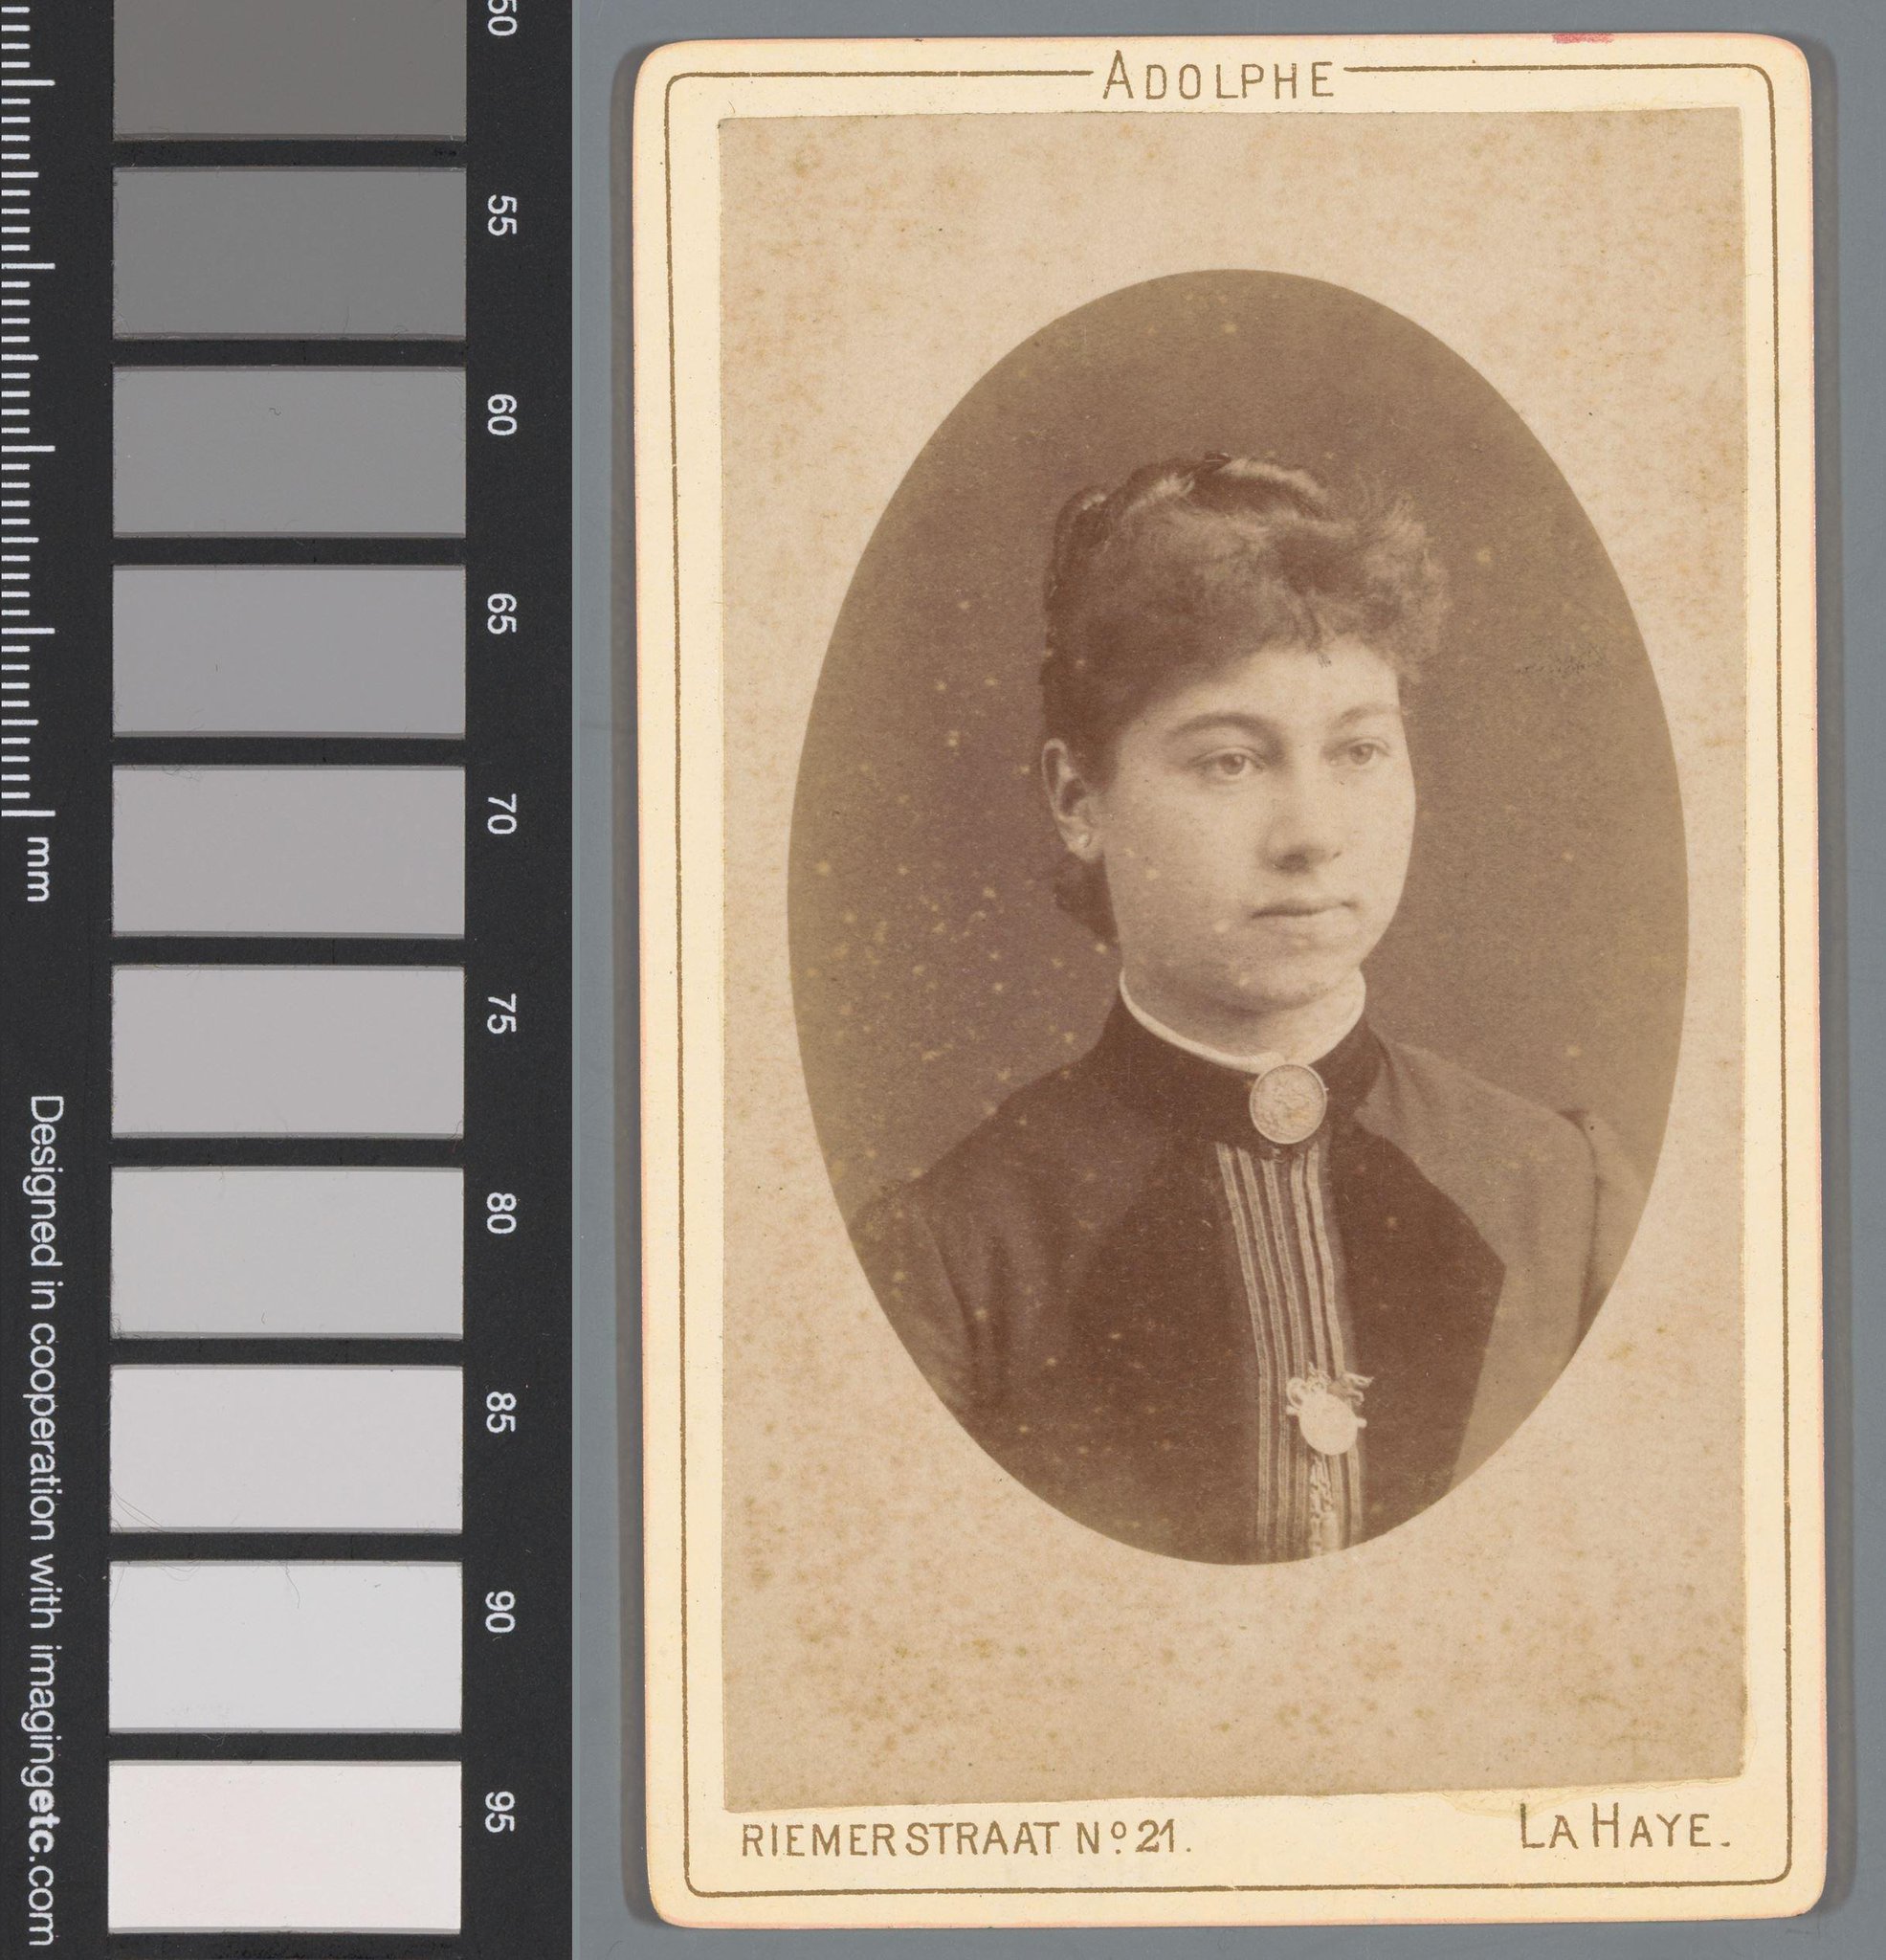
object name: carte de visite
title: Portret van een onbekende jonge vrouw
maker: adolphe zimmermans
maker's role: fotograaf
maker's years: 1858-1922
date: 1884-1913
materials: cardboard, paper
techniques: albumen print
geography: the hague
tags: adolescent, young woman, maiden, anonymous historical person portrayed, the hague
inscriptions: inscription: ‘Adolphe/ Riemerstraat No. 21. La Haye.’, inscription: ‘Adolphe Zimmermans/ Photographe./ Riemerstraat No.21/ La Haye.’